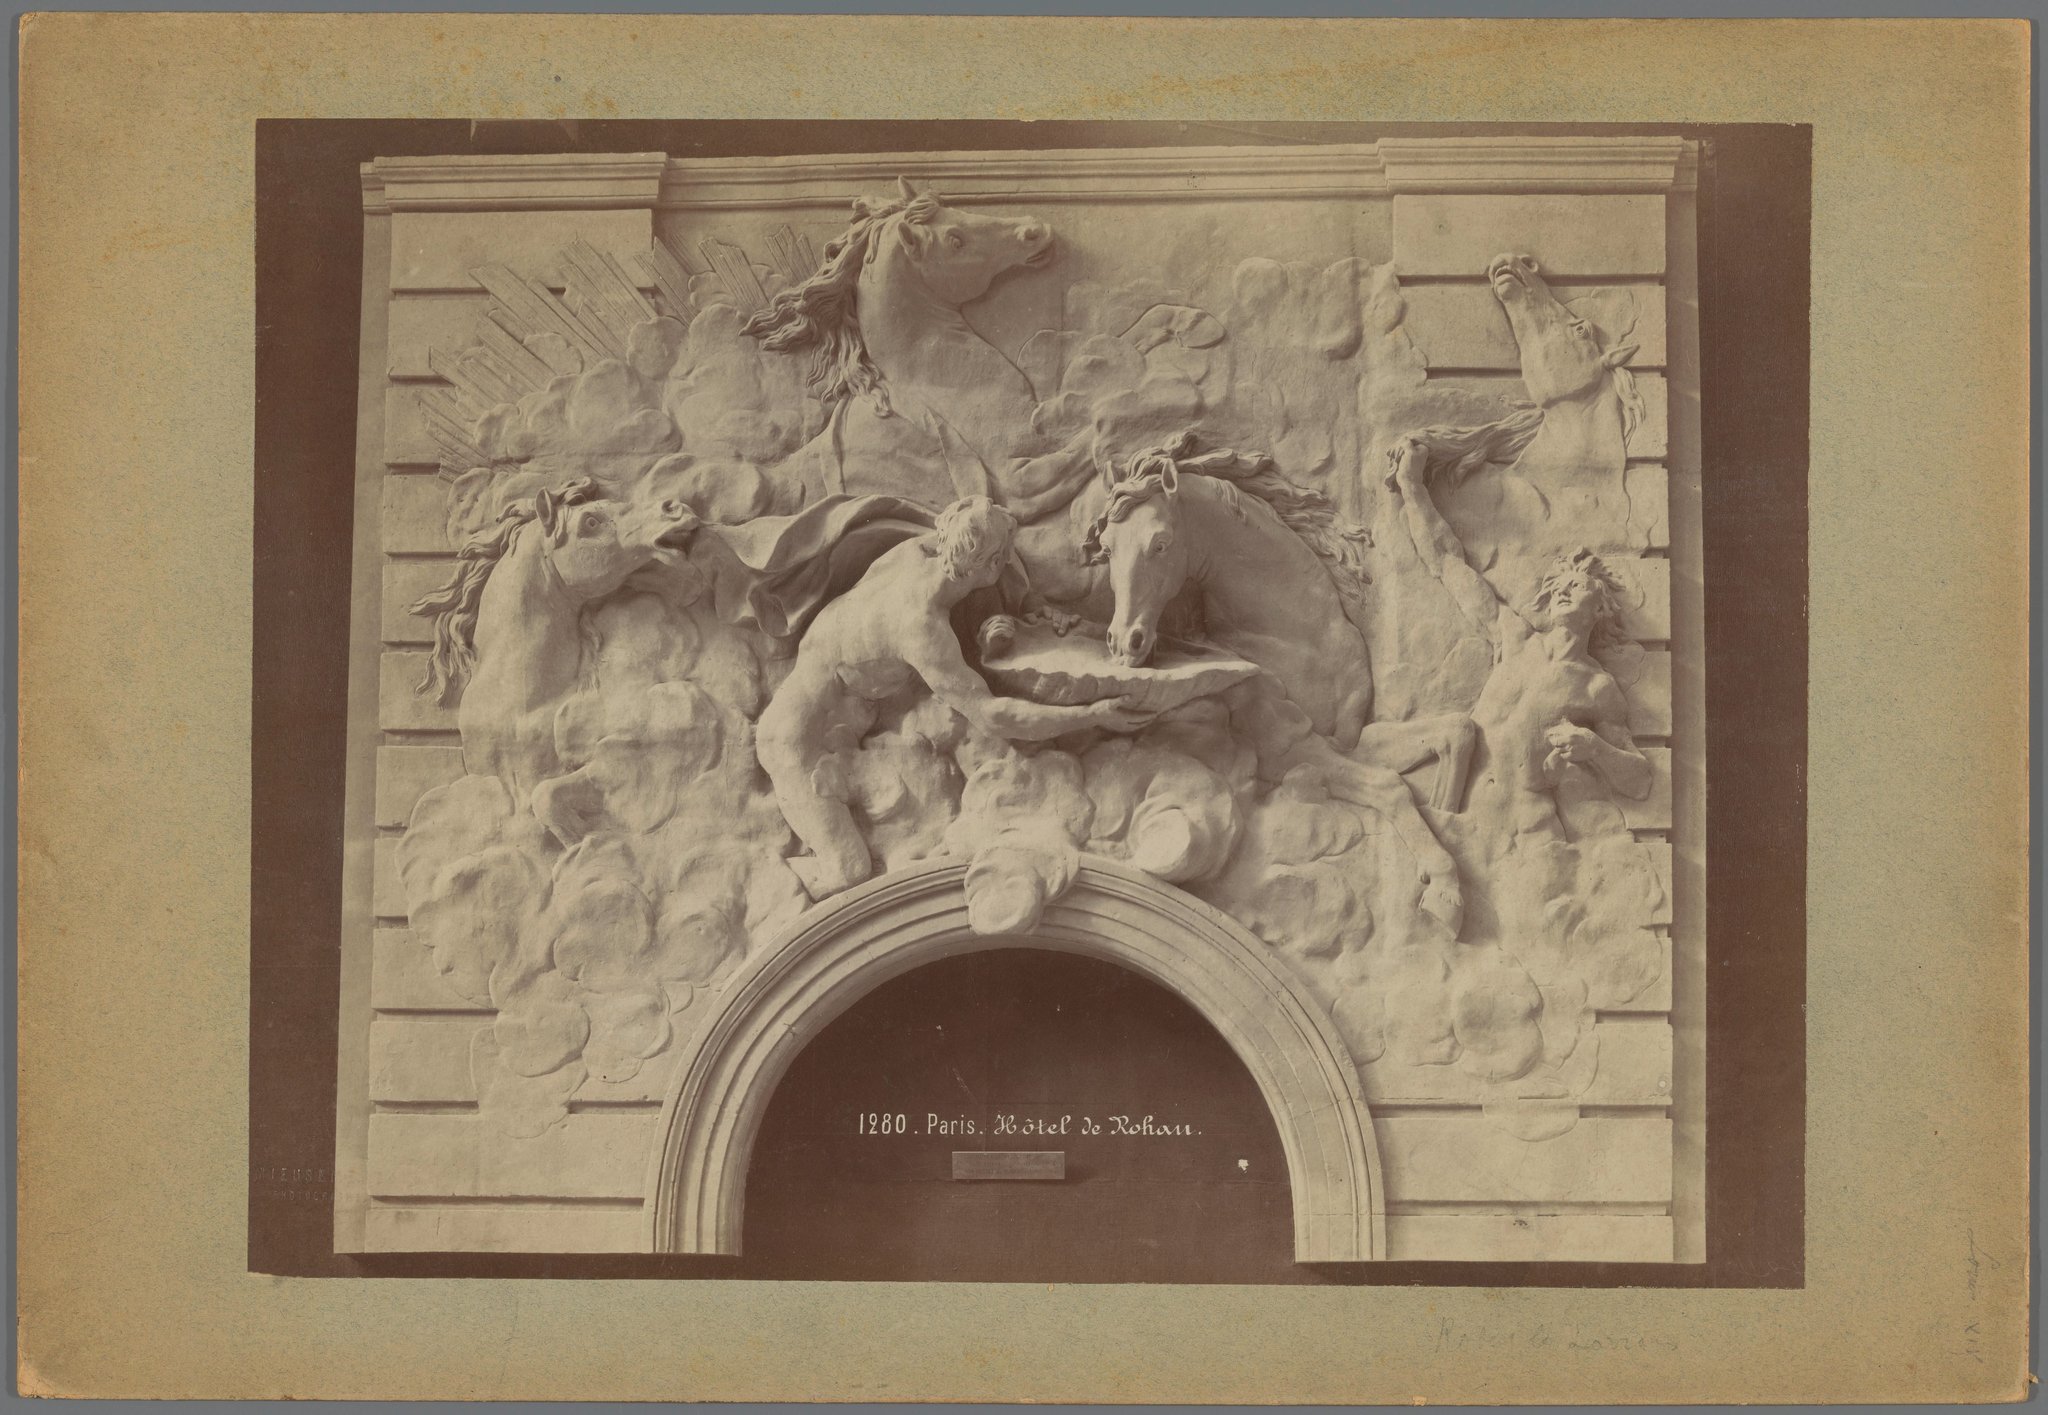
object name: photograph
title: Paris. Hôtel de Rohan.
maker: séraphin-médéric mieusement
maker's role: fotograaf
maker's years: 1840-1905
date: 1875-1900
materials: cardboard, photographic support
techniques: albumen print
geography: palais du trocadéro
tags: the horses of apollo, permanent exhibition, museum, sculpture (+ relief ~ sculpture)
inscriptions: inscription: ‘MONUMENTS HISTORIQUES’, name: ‘MIEUSEMENT PHOTOGRAPHE’, collector's mark: Lugt 3937, inscription: ‘Louis XIV’, name: ‘KUNSTBOEKHANDEL J. A. G. DE LEUR PHOTOGRAAF - UITGEVER HUIGENSPARK, 40b. DEN HAAG.’, number: ‘No. 1280.’